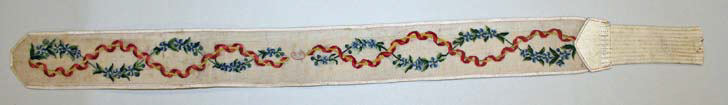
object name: suspender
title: Suspenders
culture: european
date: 1801-1900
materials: silk